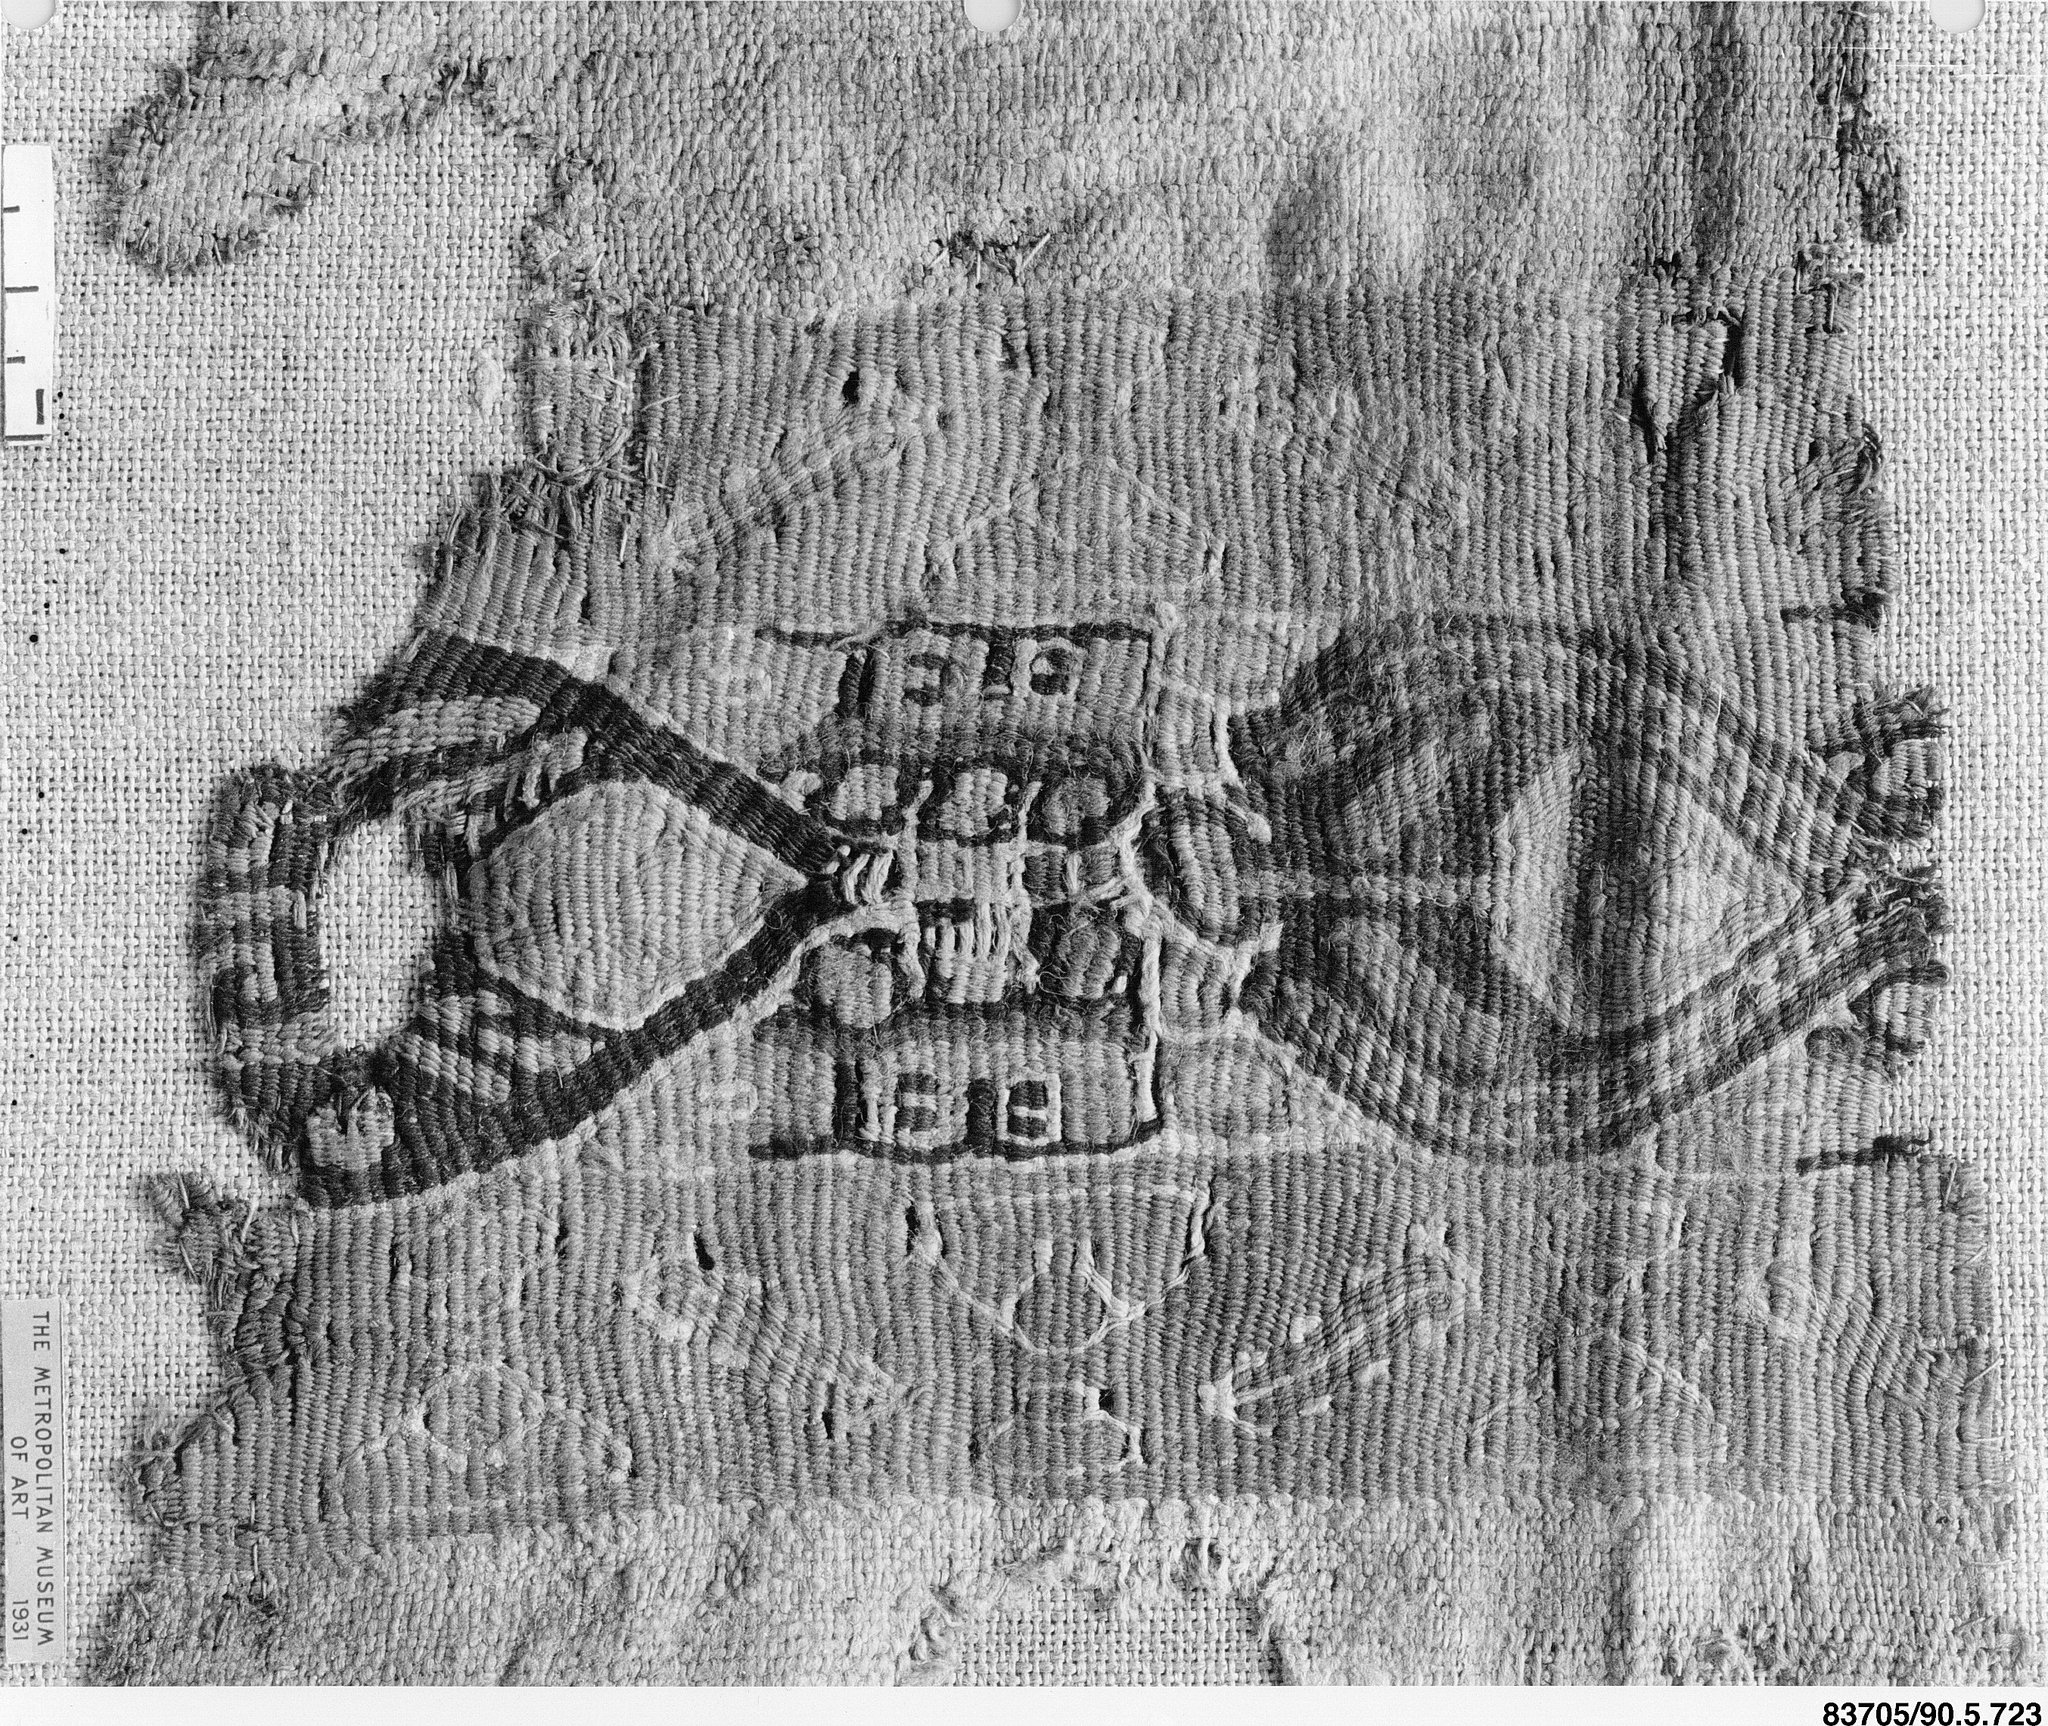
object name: textile fragment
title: Fragment of Shoulder Band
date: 401-600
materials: linen, wool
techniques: weave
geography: egypt